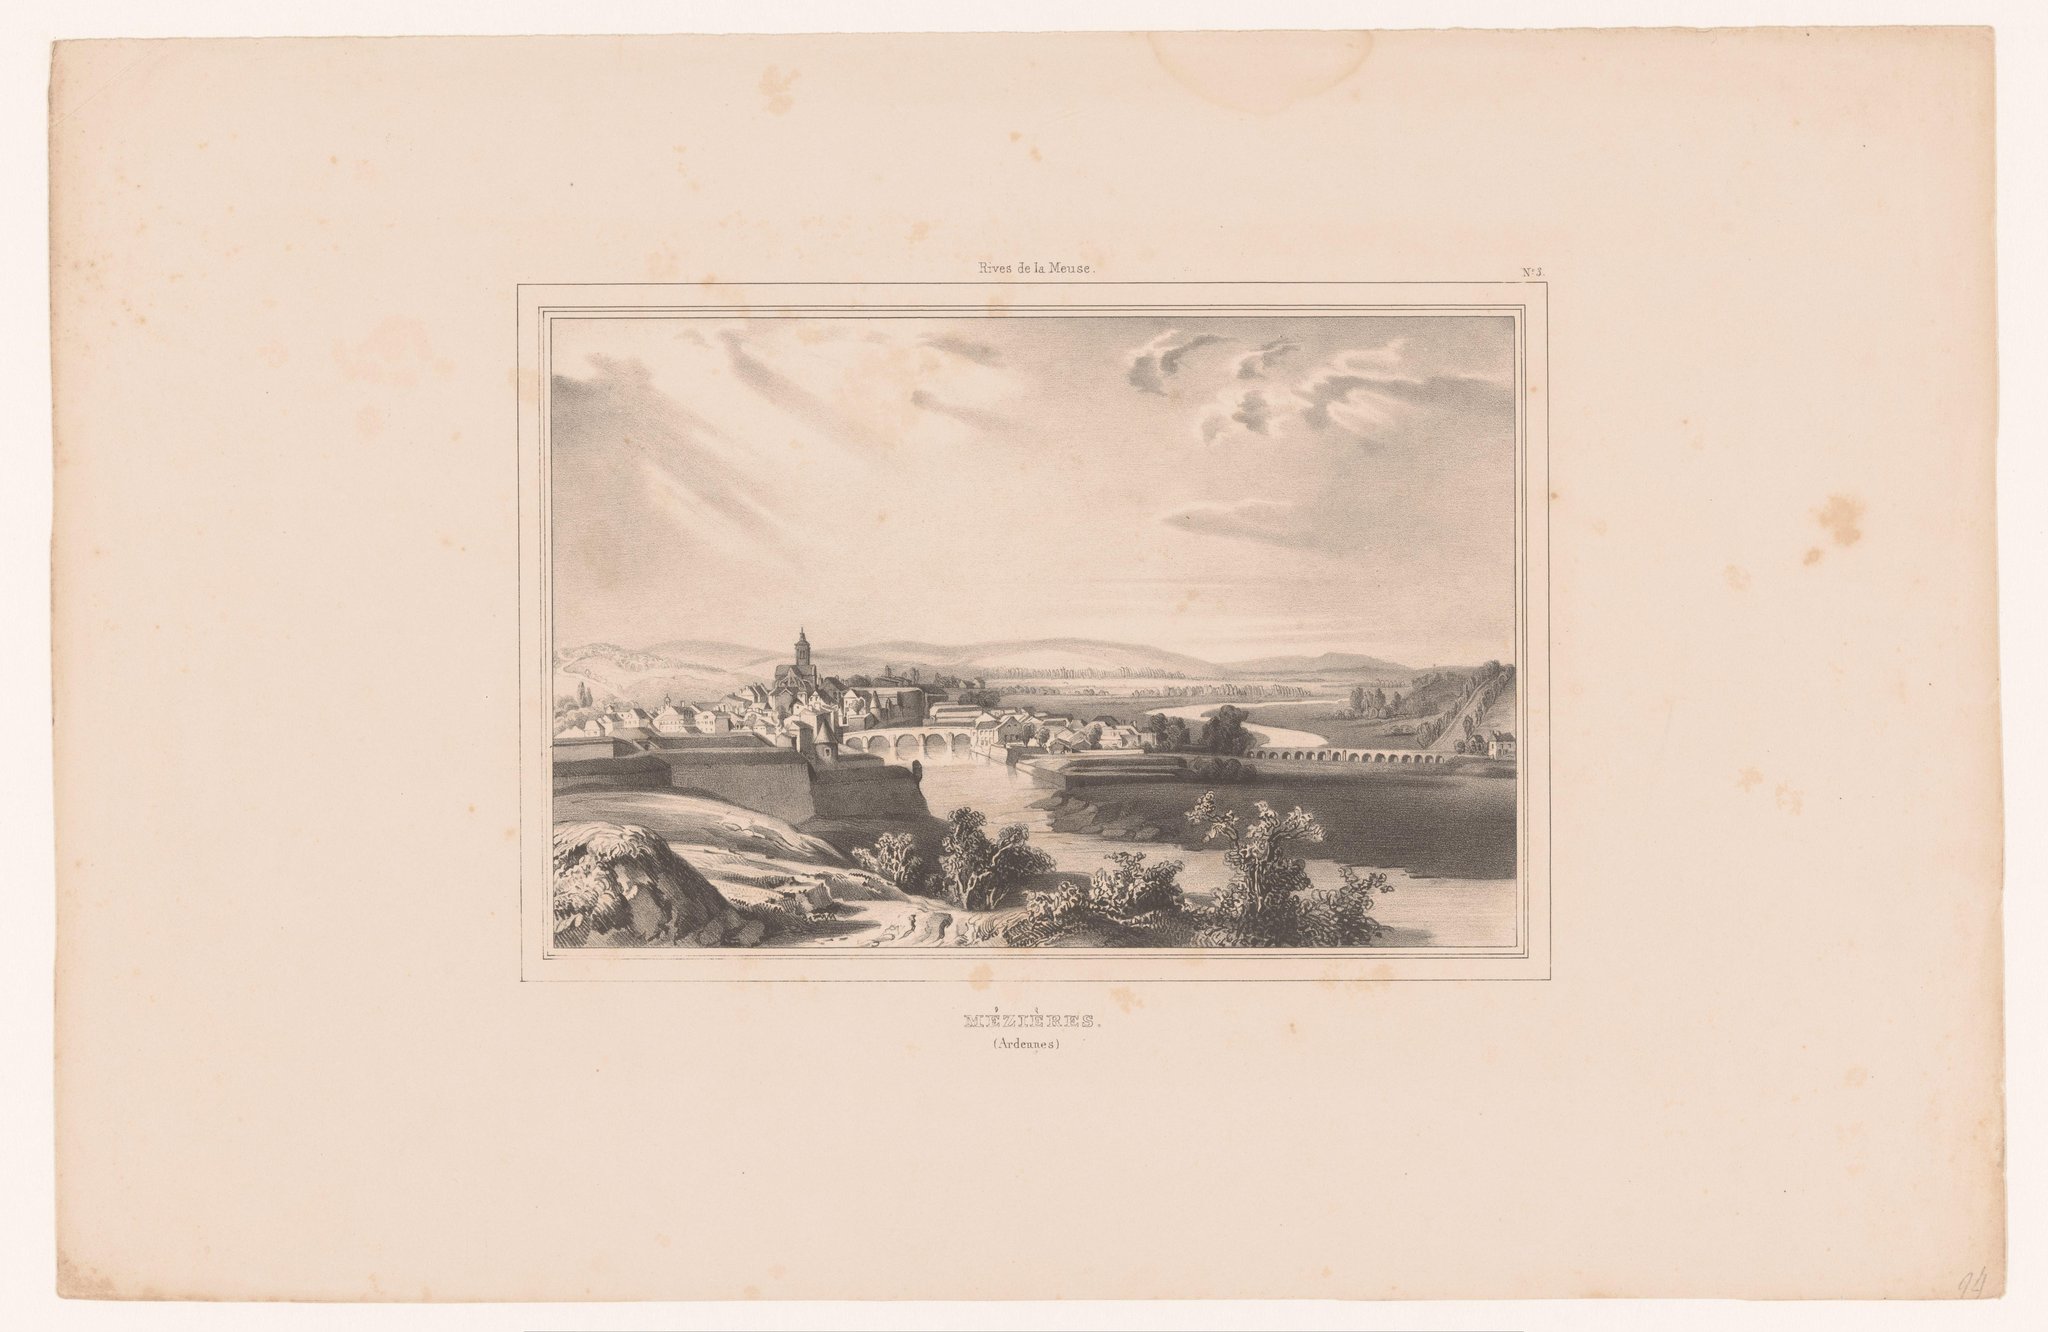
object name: print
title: Gezicht op Mézières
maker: Anonymous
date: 1800-1850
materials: paper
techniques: lithograph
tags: city-view, and landscape with man-made constructions, river, landscape with bridge, viaduct or aqueduct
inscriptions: collector's mark: Lugt 2228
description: Prent maakt mogelijk deel uit van een serie.